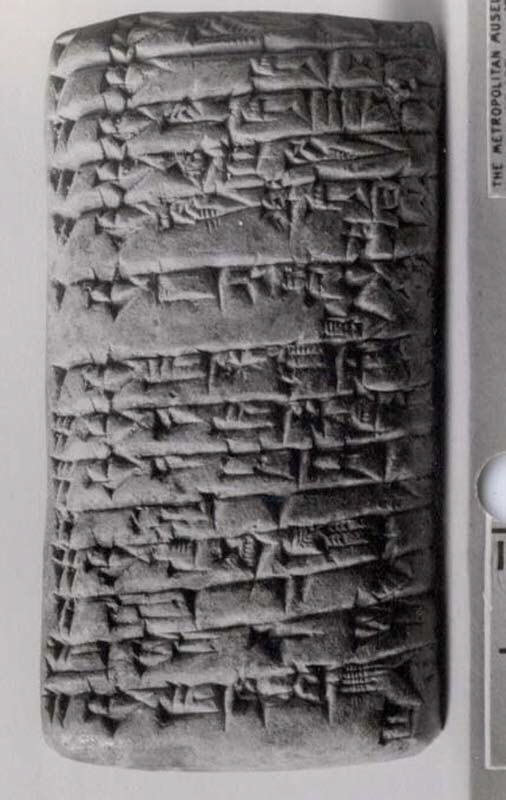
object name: cuneiform tablet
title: Cuneiform tablet: receipt of cattle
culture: neo-sumerian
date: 2041 BCE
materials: clay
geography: mesopotamia